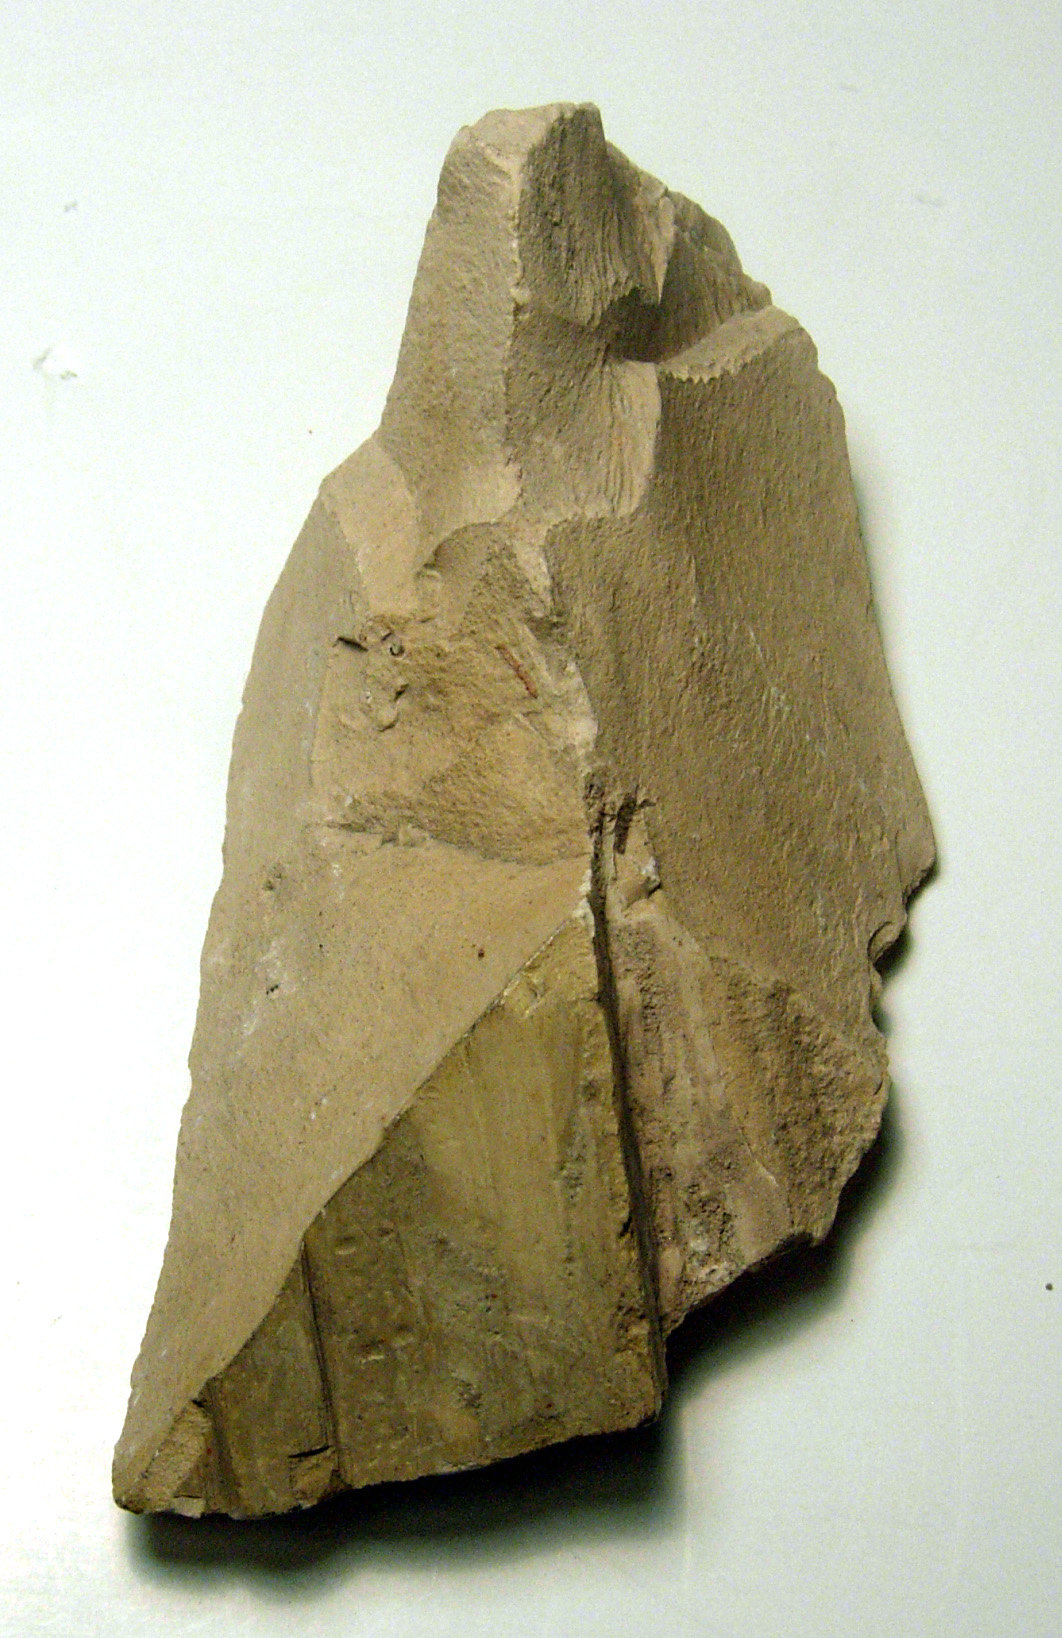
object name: relief, tomb of nespekashuty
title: Raised relief fragment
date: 664-610 BCE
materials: limestone, varnish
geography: egypt